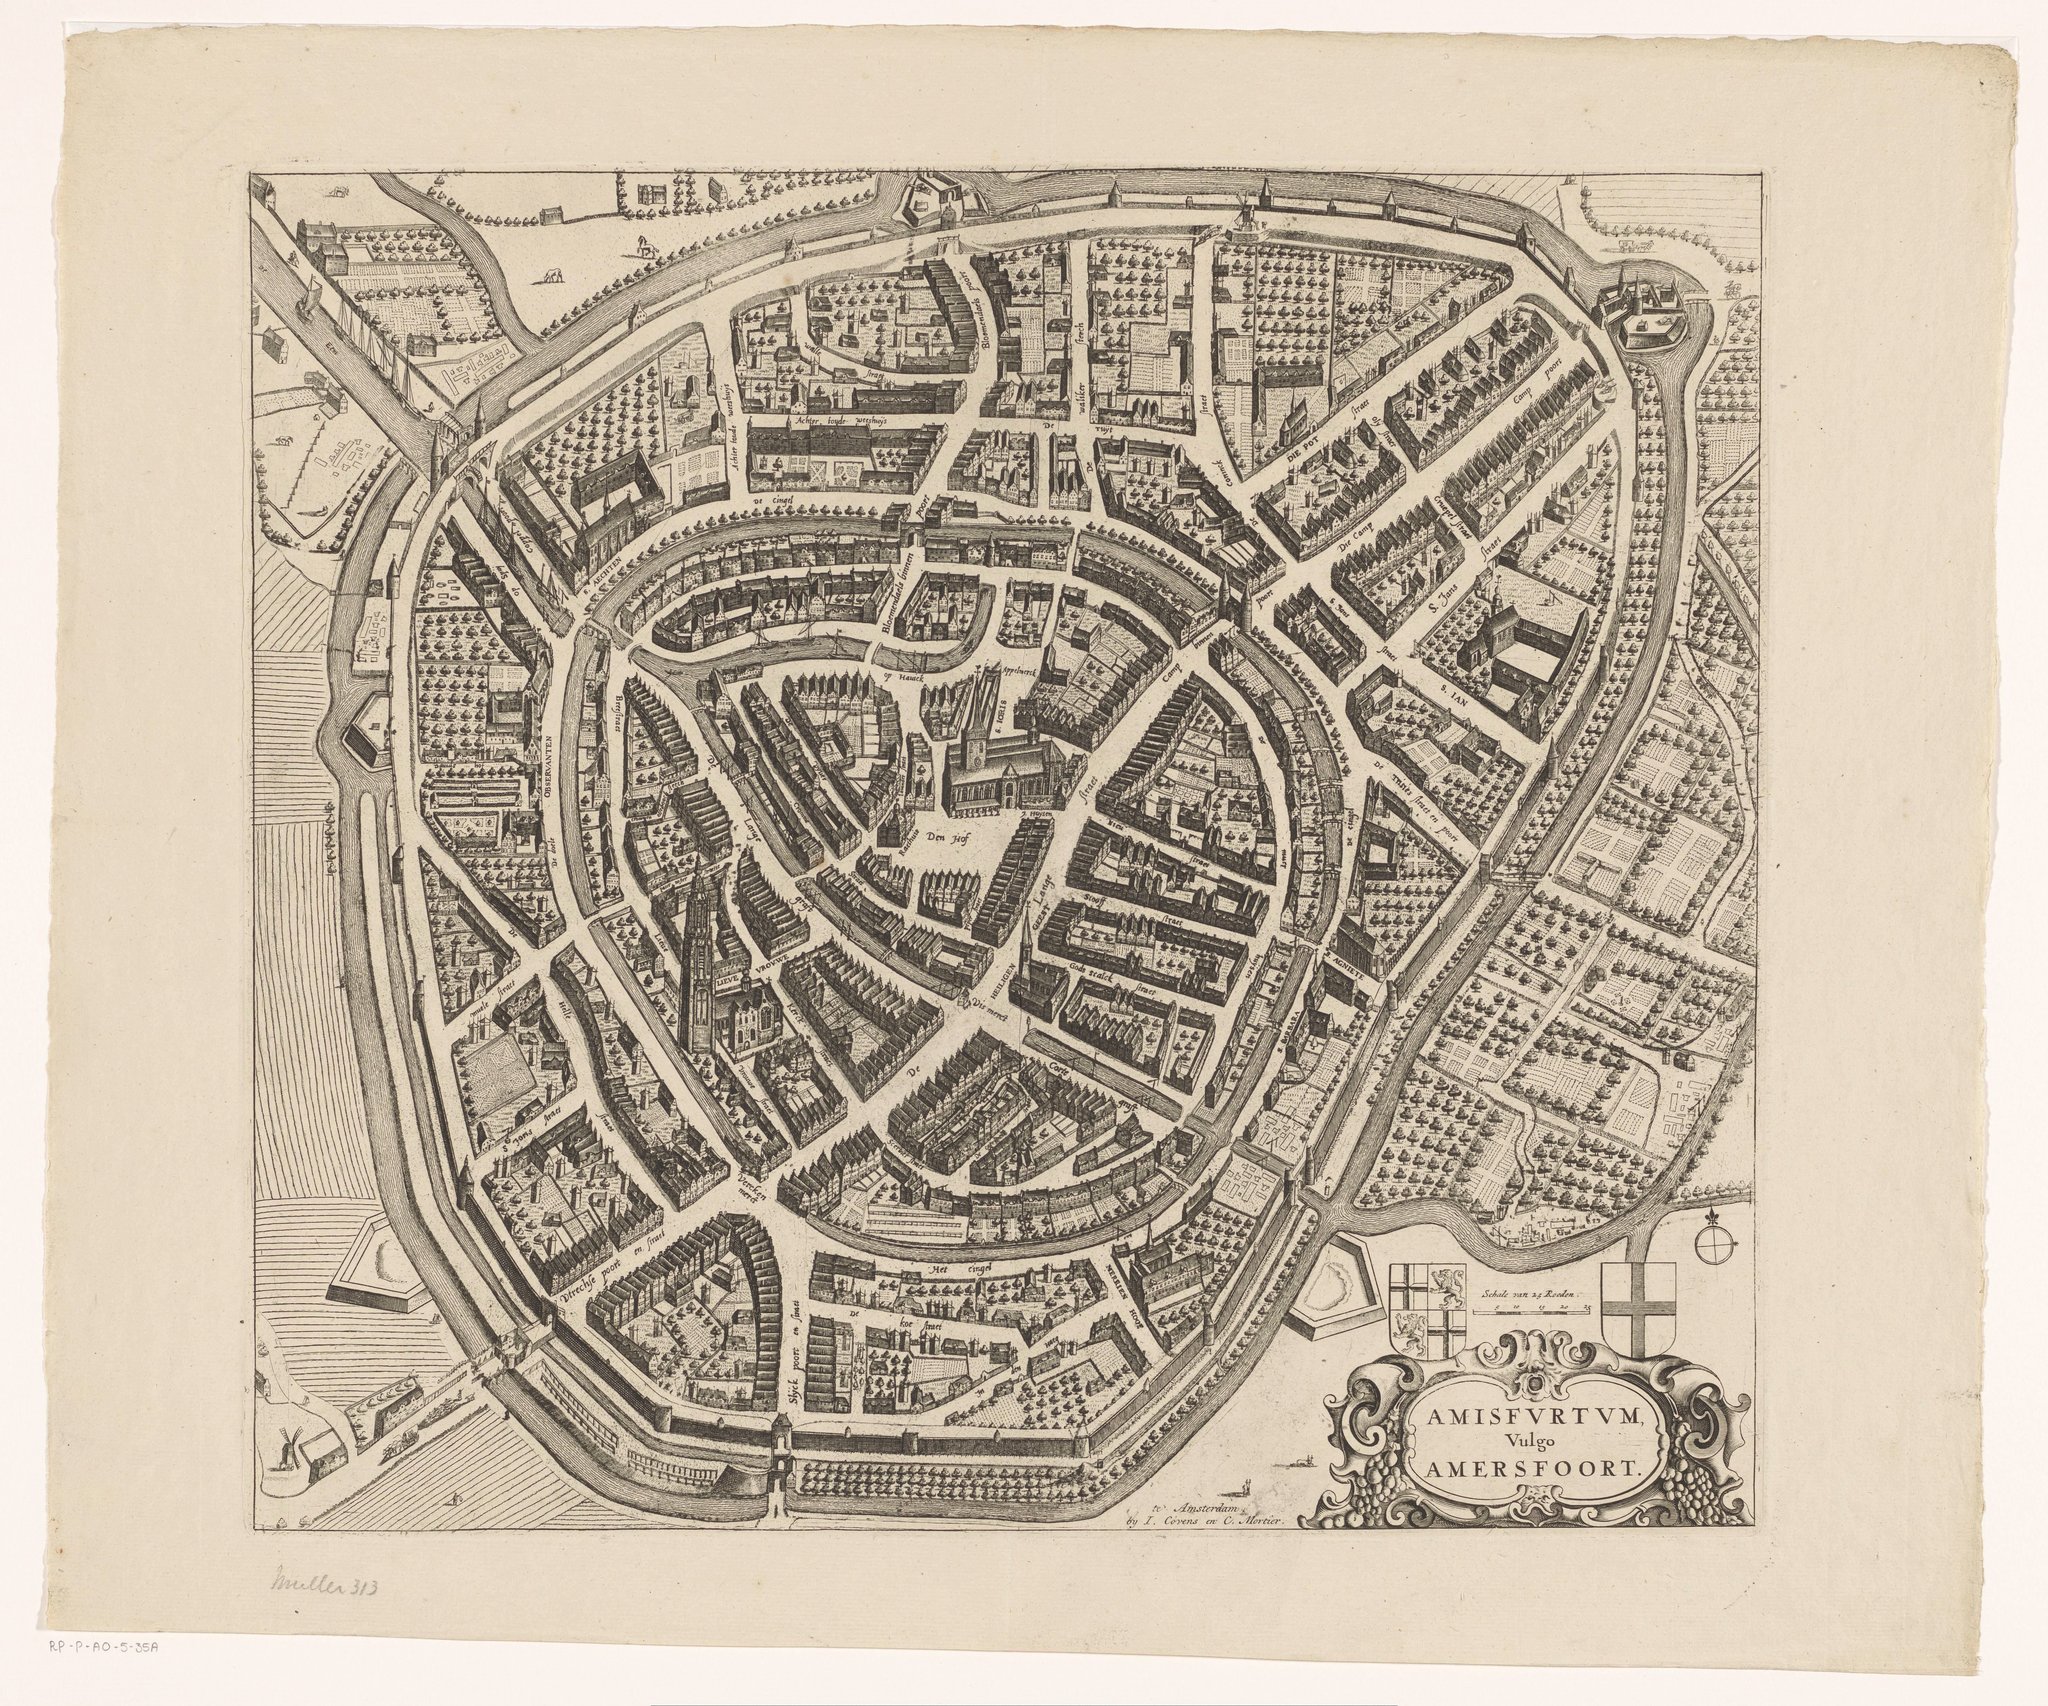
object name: area plan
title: Plattegrond van Amersfoort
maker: Anonymous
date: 1657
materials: paper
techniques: engraving, etching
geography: amsterdam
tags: coat of arms (as symbol of the state, etc.), maps of cities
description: Eerste staat van deze prent (niet huidige) voor het eerst ook gebruikt in: Theatrum Urbium Celebriorum totius Belgii sive Germaniae Inferioris. 2 delen. Amsterdam: Johannes Janssonius, 1657, dl. 2.